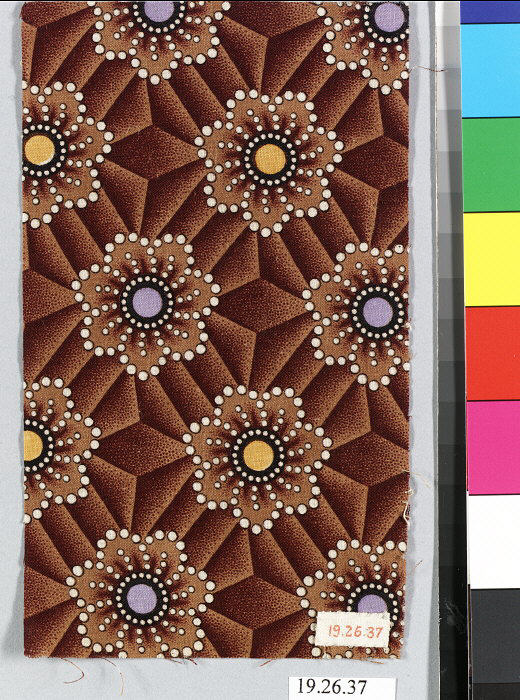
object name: sample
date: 1840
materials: cotton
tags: flowers